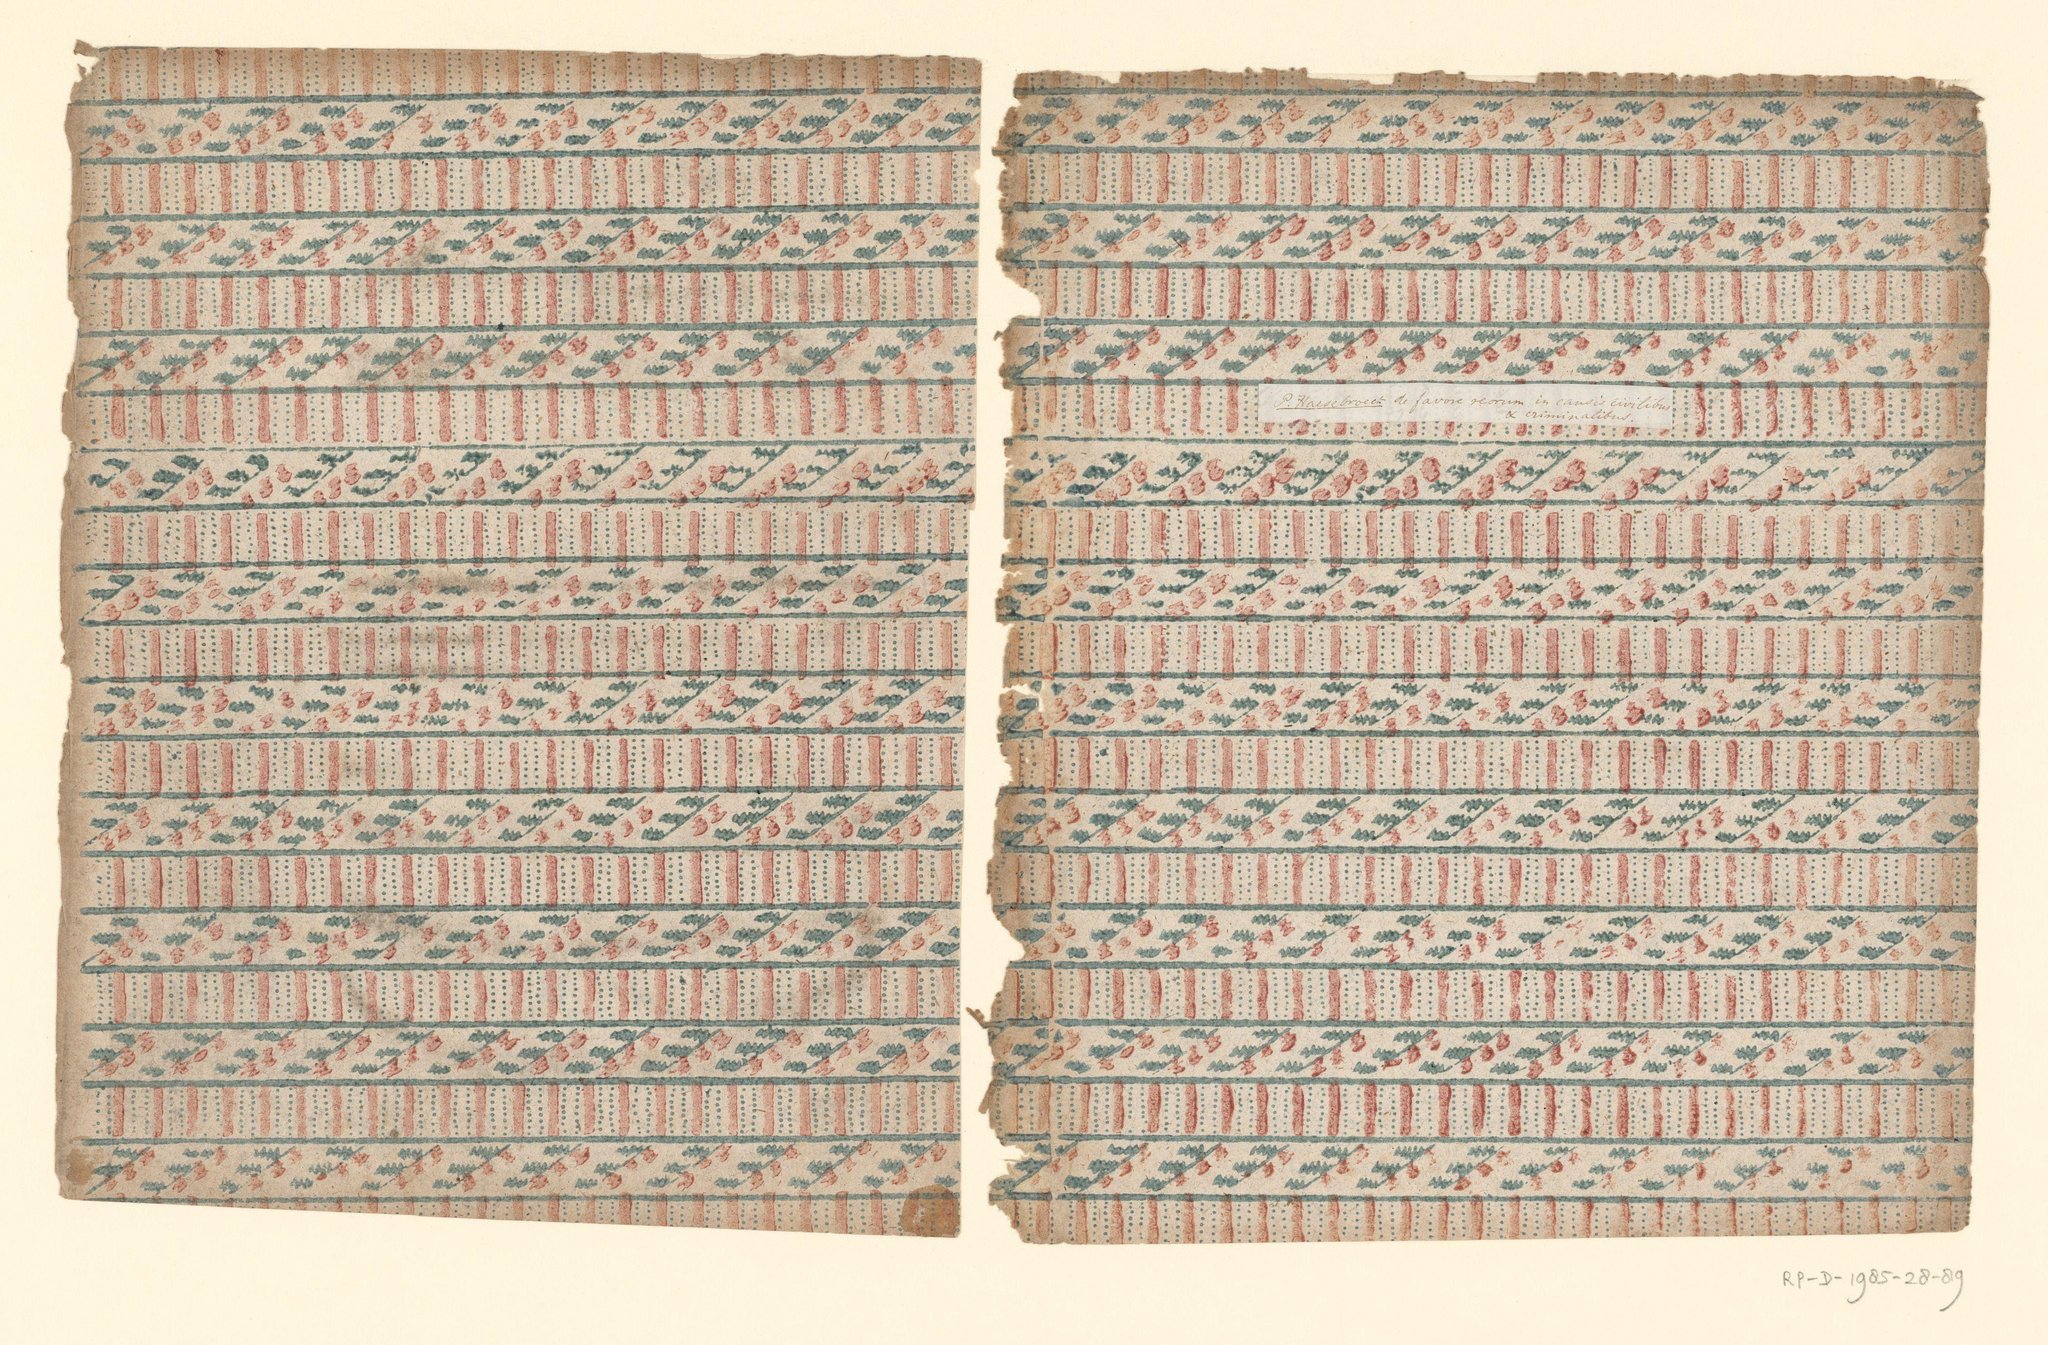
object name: wrapper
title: Twee bladen met banenpatroon van bladeren en strepen met punten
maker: Anonymous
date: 1750-1900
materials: paper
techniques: printing block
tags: ornament derived from plant forms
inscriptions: collector's mark: Lugt 2228, collector's mark: Lugt 2760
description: Twee bladen met horizontaal banenpatroon van bladeren en strepen met punten. Met etiket met opschrift: 'P. Haesebroeck ... criminalibus.' Twee losse helften van een omslag.